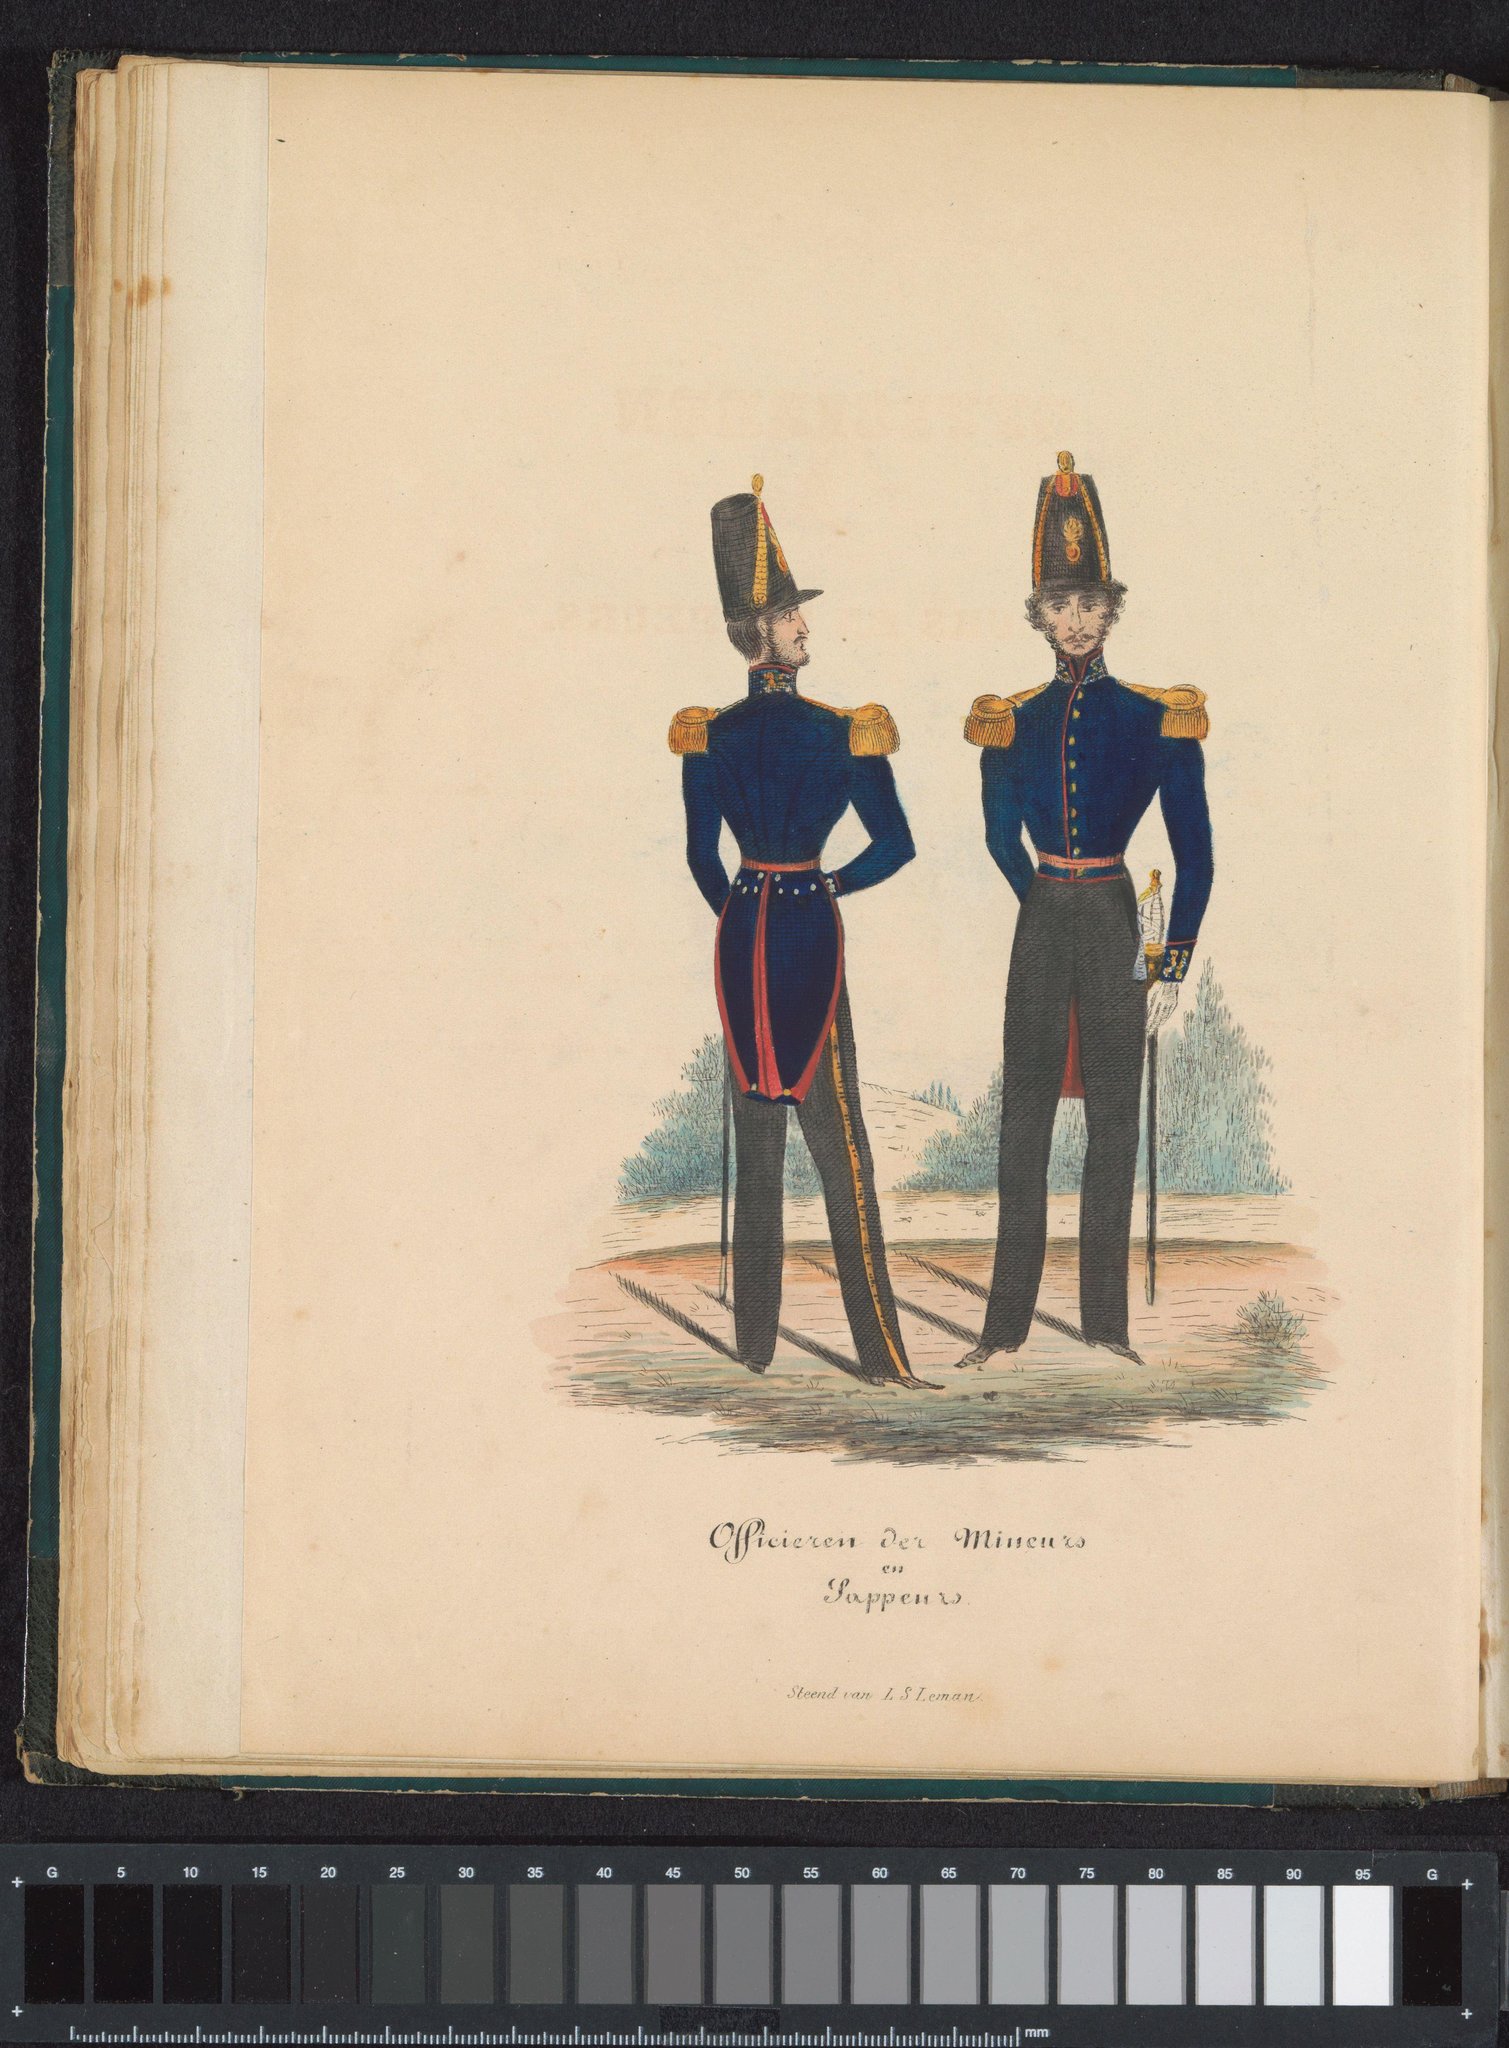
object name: costume print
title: Officieren der Mineurs en Sappeurs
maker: louis salomon leman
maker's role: steendrukker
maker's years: 1818-1889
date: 1845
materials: paper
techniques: hand coloring, lithograph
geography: netherlands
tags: (military) uniforms, netherlands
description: Uniform van de officieren van de mineurs en sappeurs. Illustratie in een boek uit 1845 over de uniformen en kledingstukken van de Nederlandse land-, zeemacht en schutterijen in Nederland en in de overzeese gebiedsdelen.